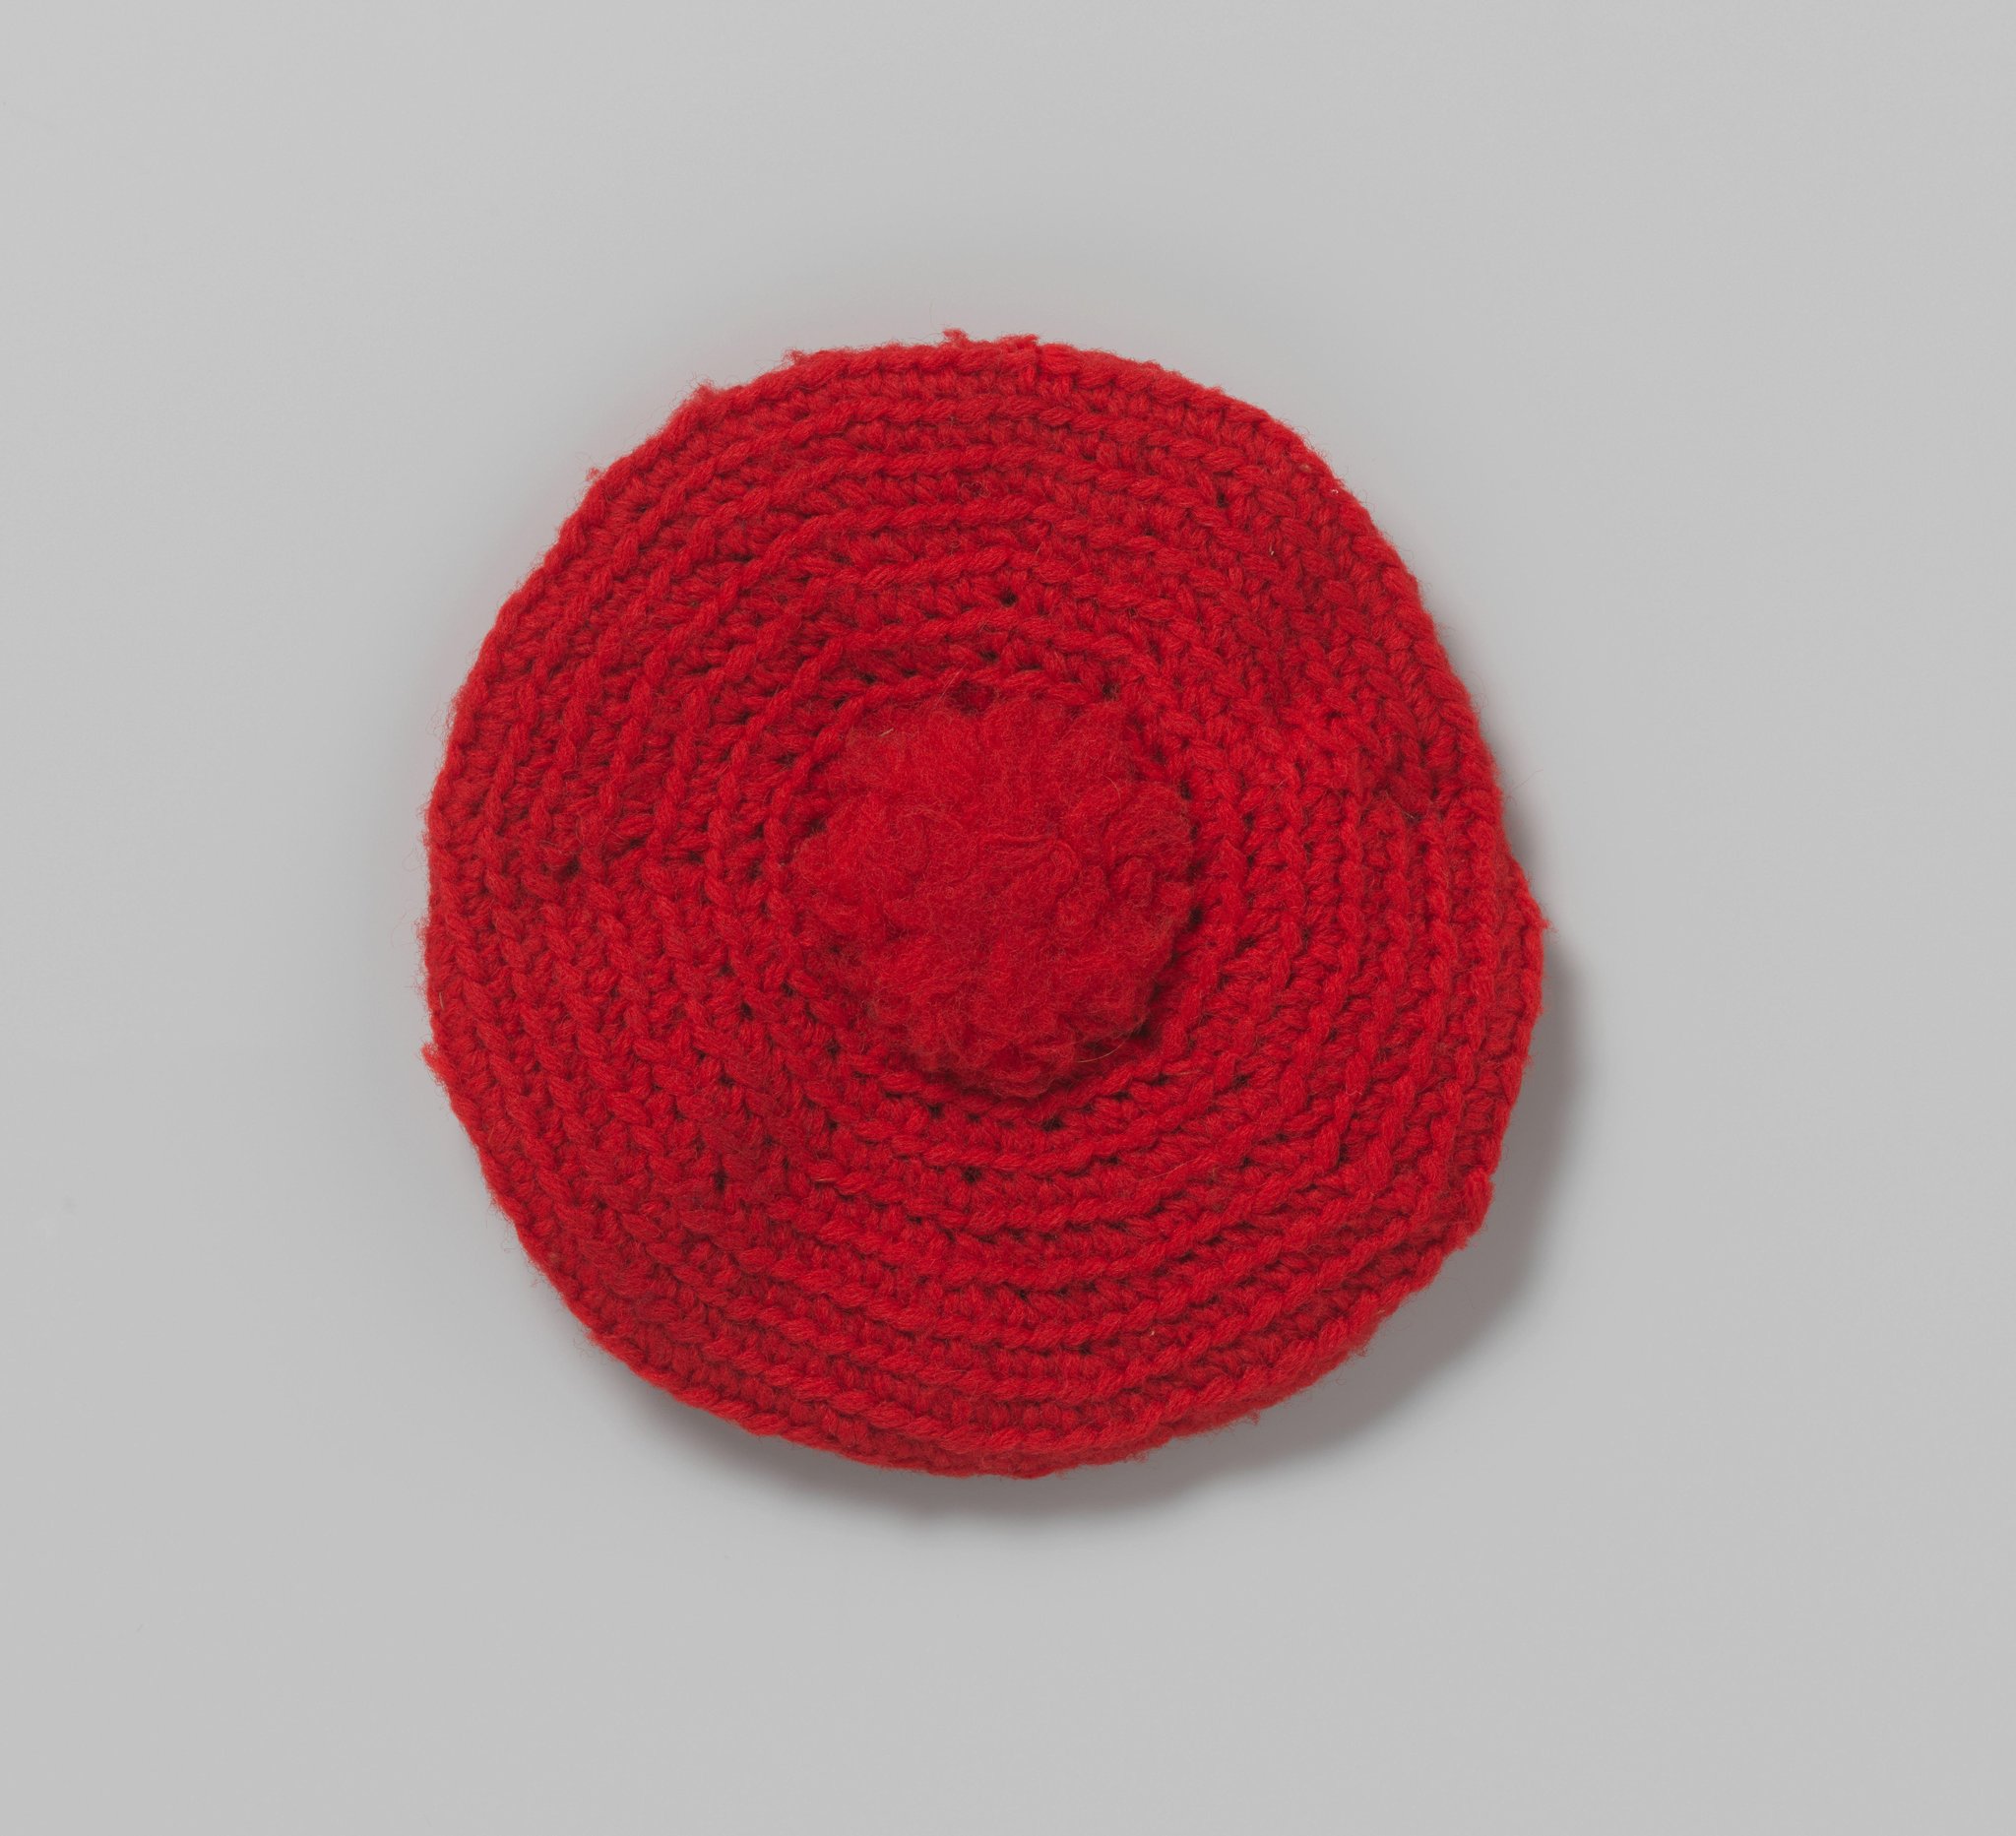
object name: doll's clothing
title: Baret van rode wol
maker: Anonymous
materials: wool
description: Pop met porseleinen kop, lijfje met leer bekleed, doorlopend in leren benen, met zes stuks poppenkleren.